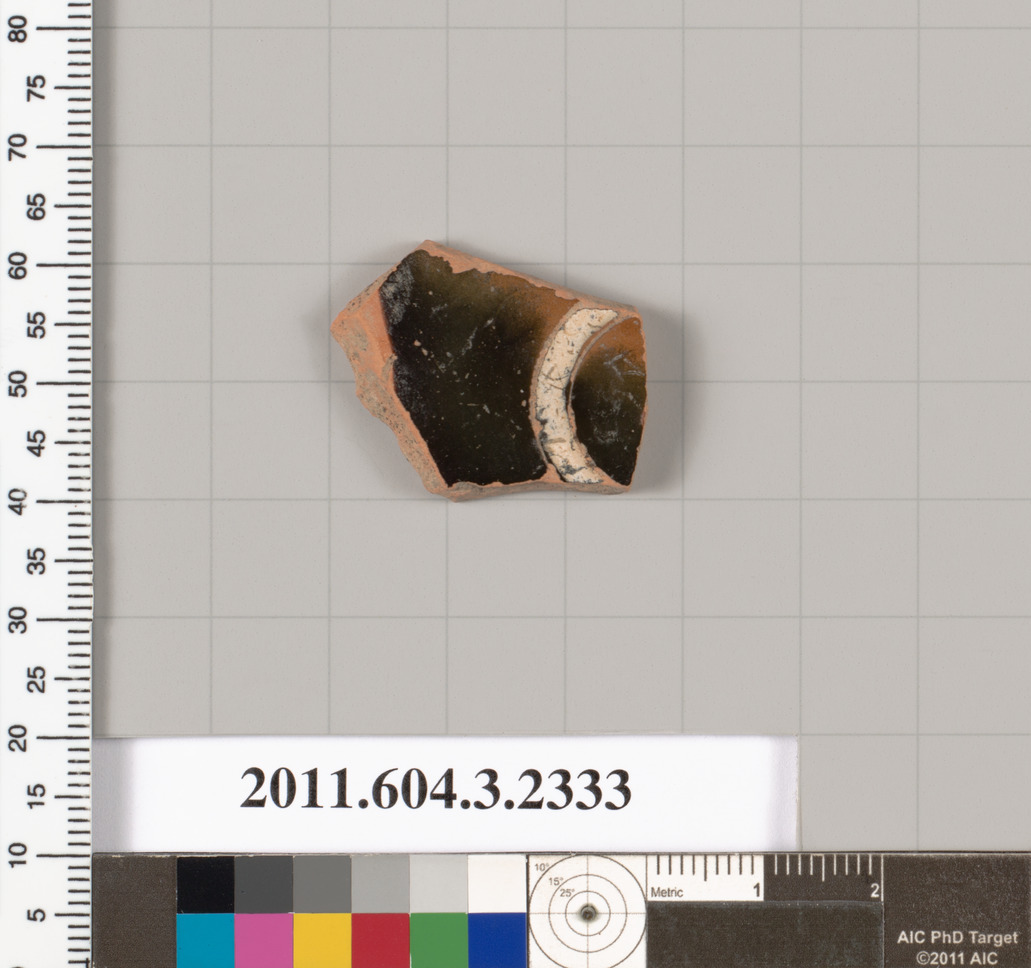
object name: kylix fragment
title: Terracotta fragment of a kylix: eye-cup (drinking cup)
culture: greek, attic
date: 530-510 BCE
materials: terracotta